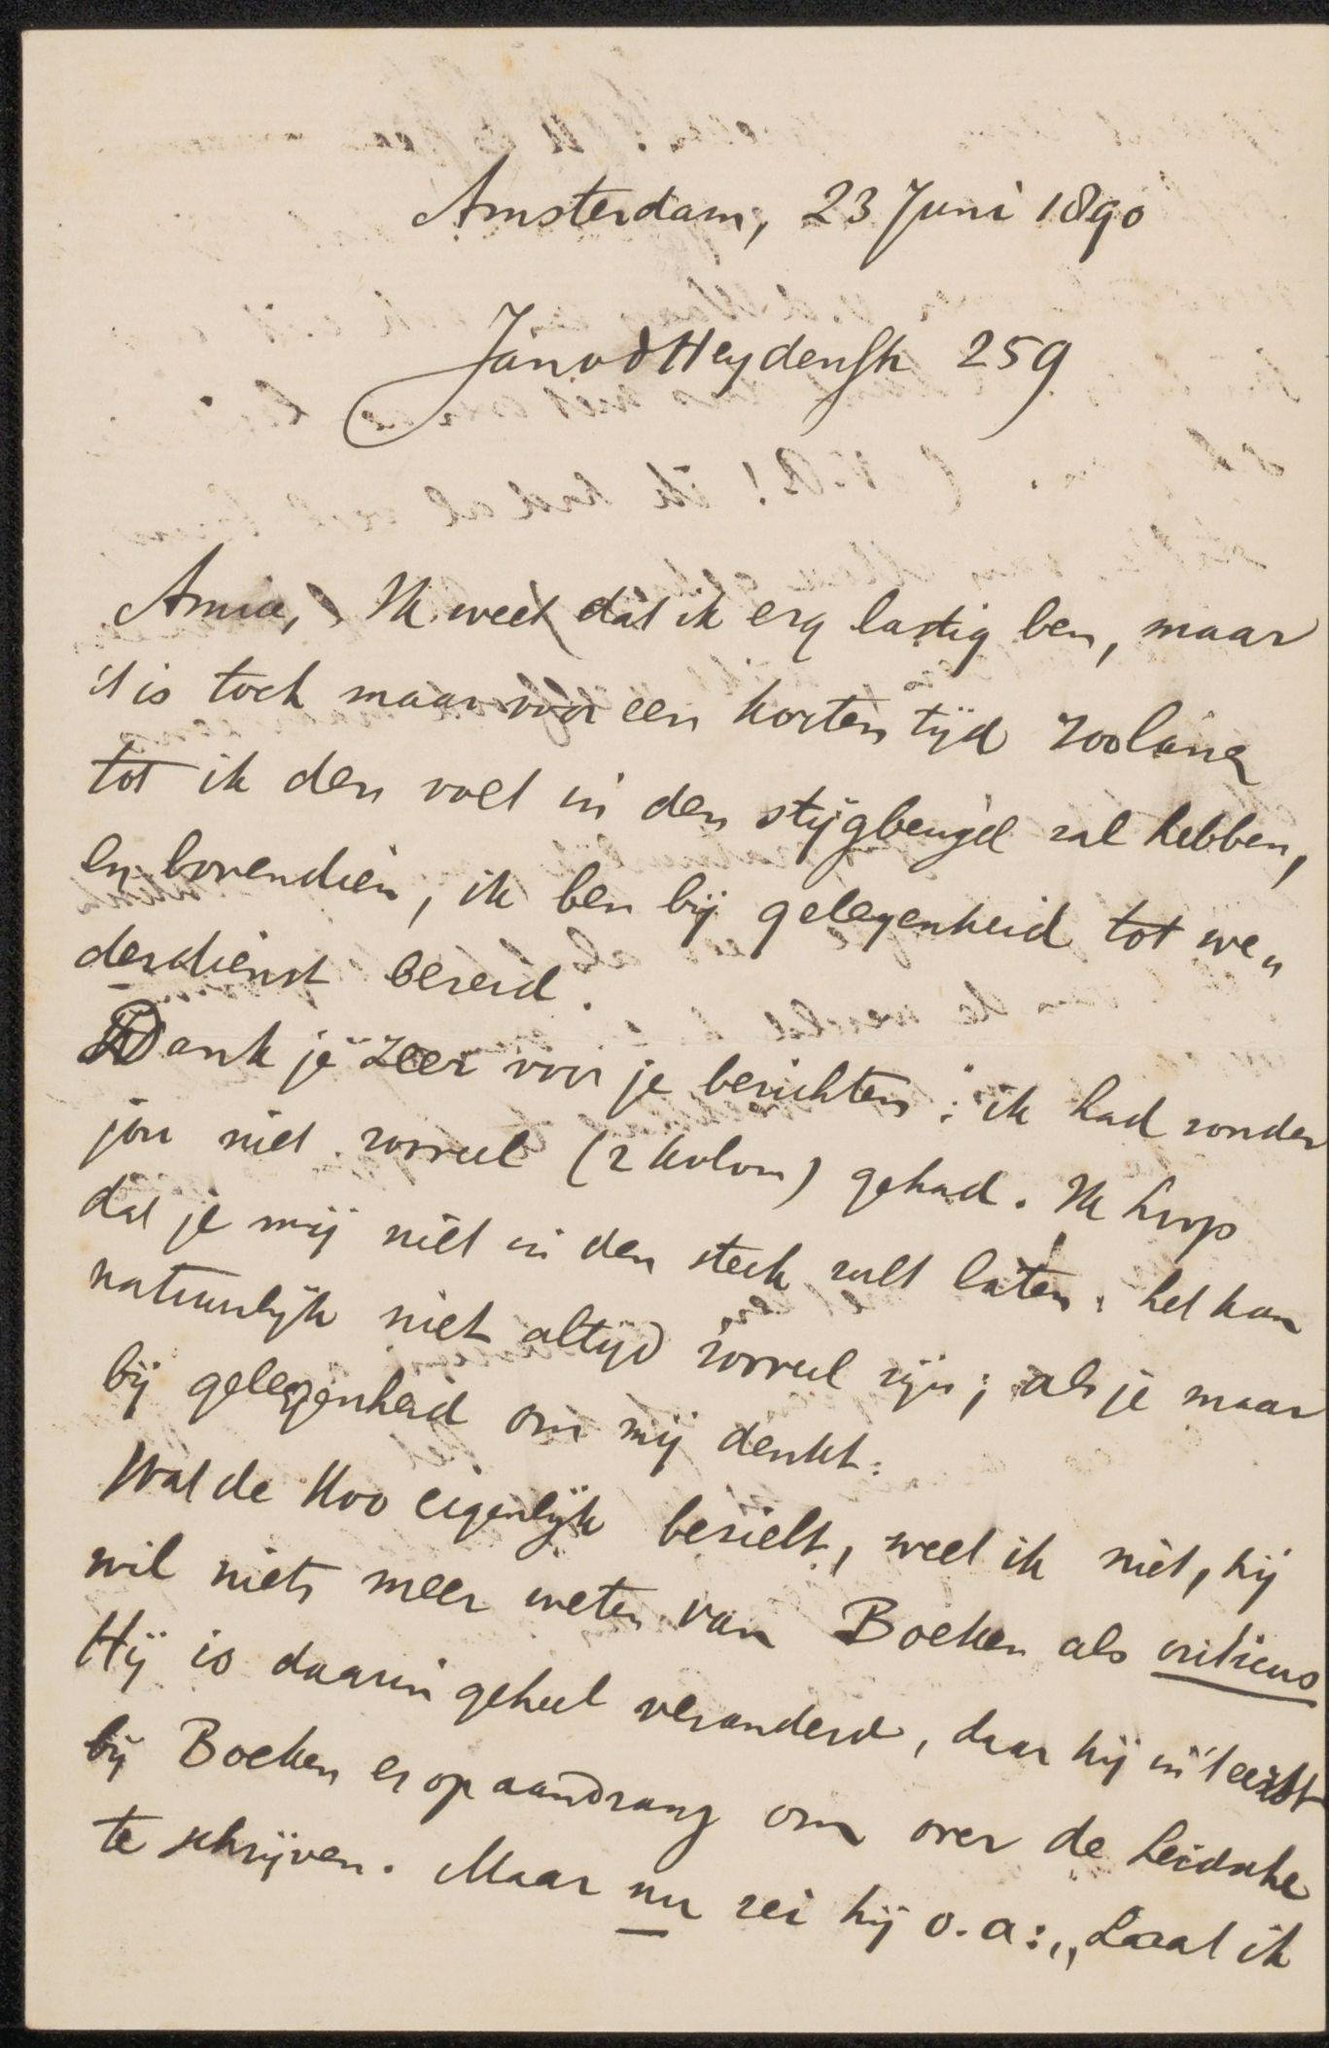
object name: letter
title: Brief aan Jan Veth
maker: willem kloos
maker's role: dichter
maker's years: 1859-1938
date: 1890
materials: ink, paper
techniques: pen, writing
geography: amsterdam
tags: dordrecht, amsterdam, painter, print maker, draughtsman, designer, jan veth, nicolaas van der waay, maurits van der valk, utrecht, etha fles, hein boeken, liège, johannes de koo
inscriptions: watermark, collector's mark: ‘RPK’